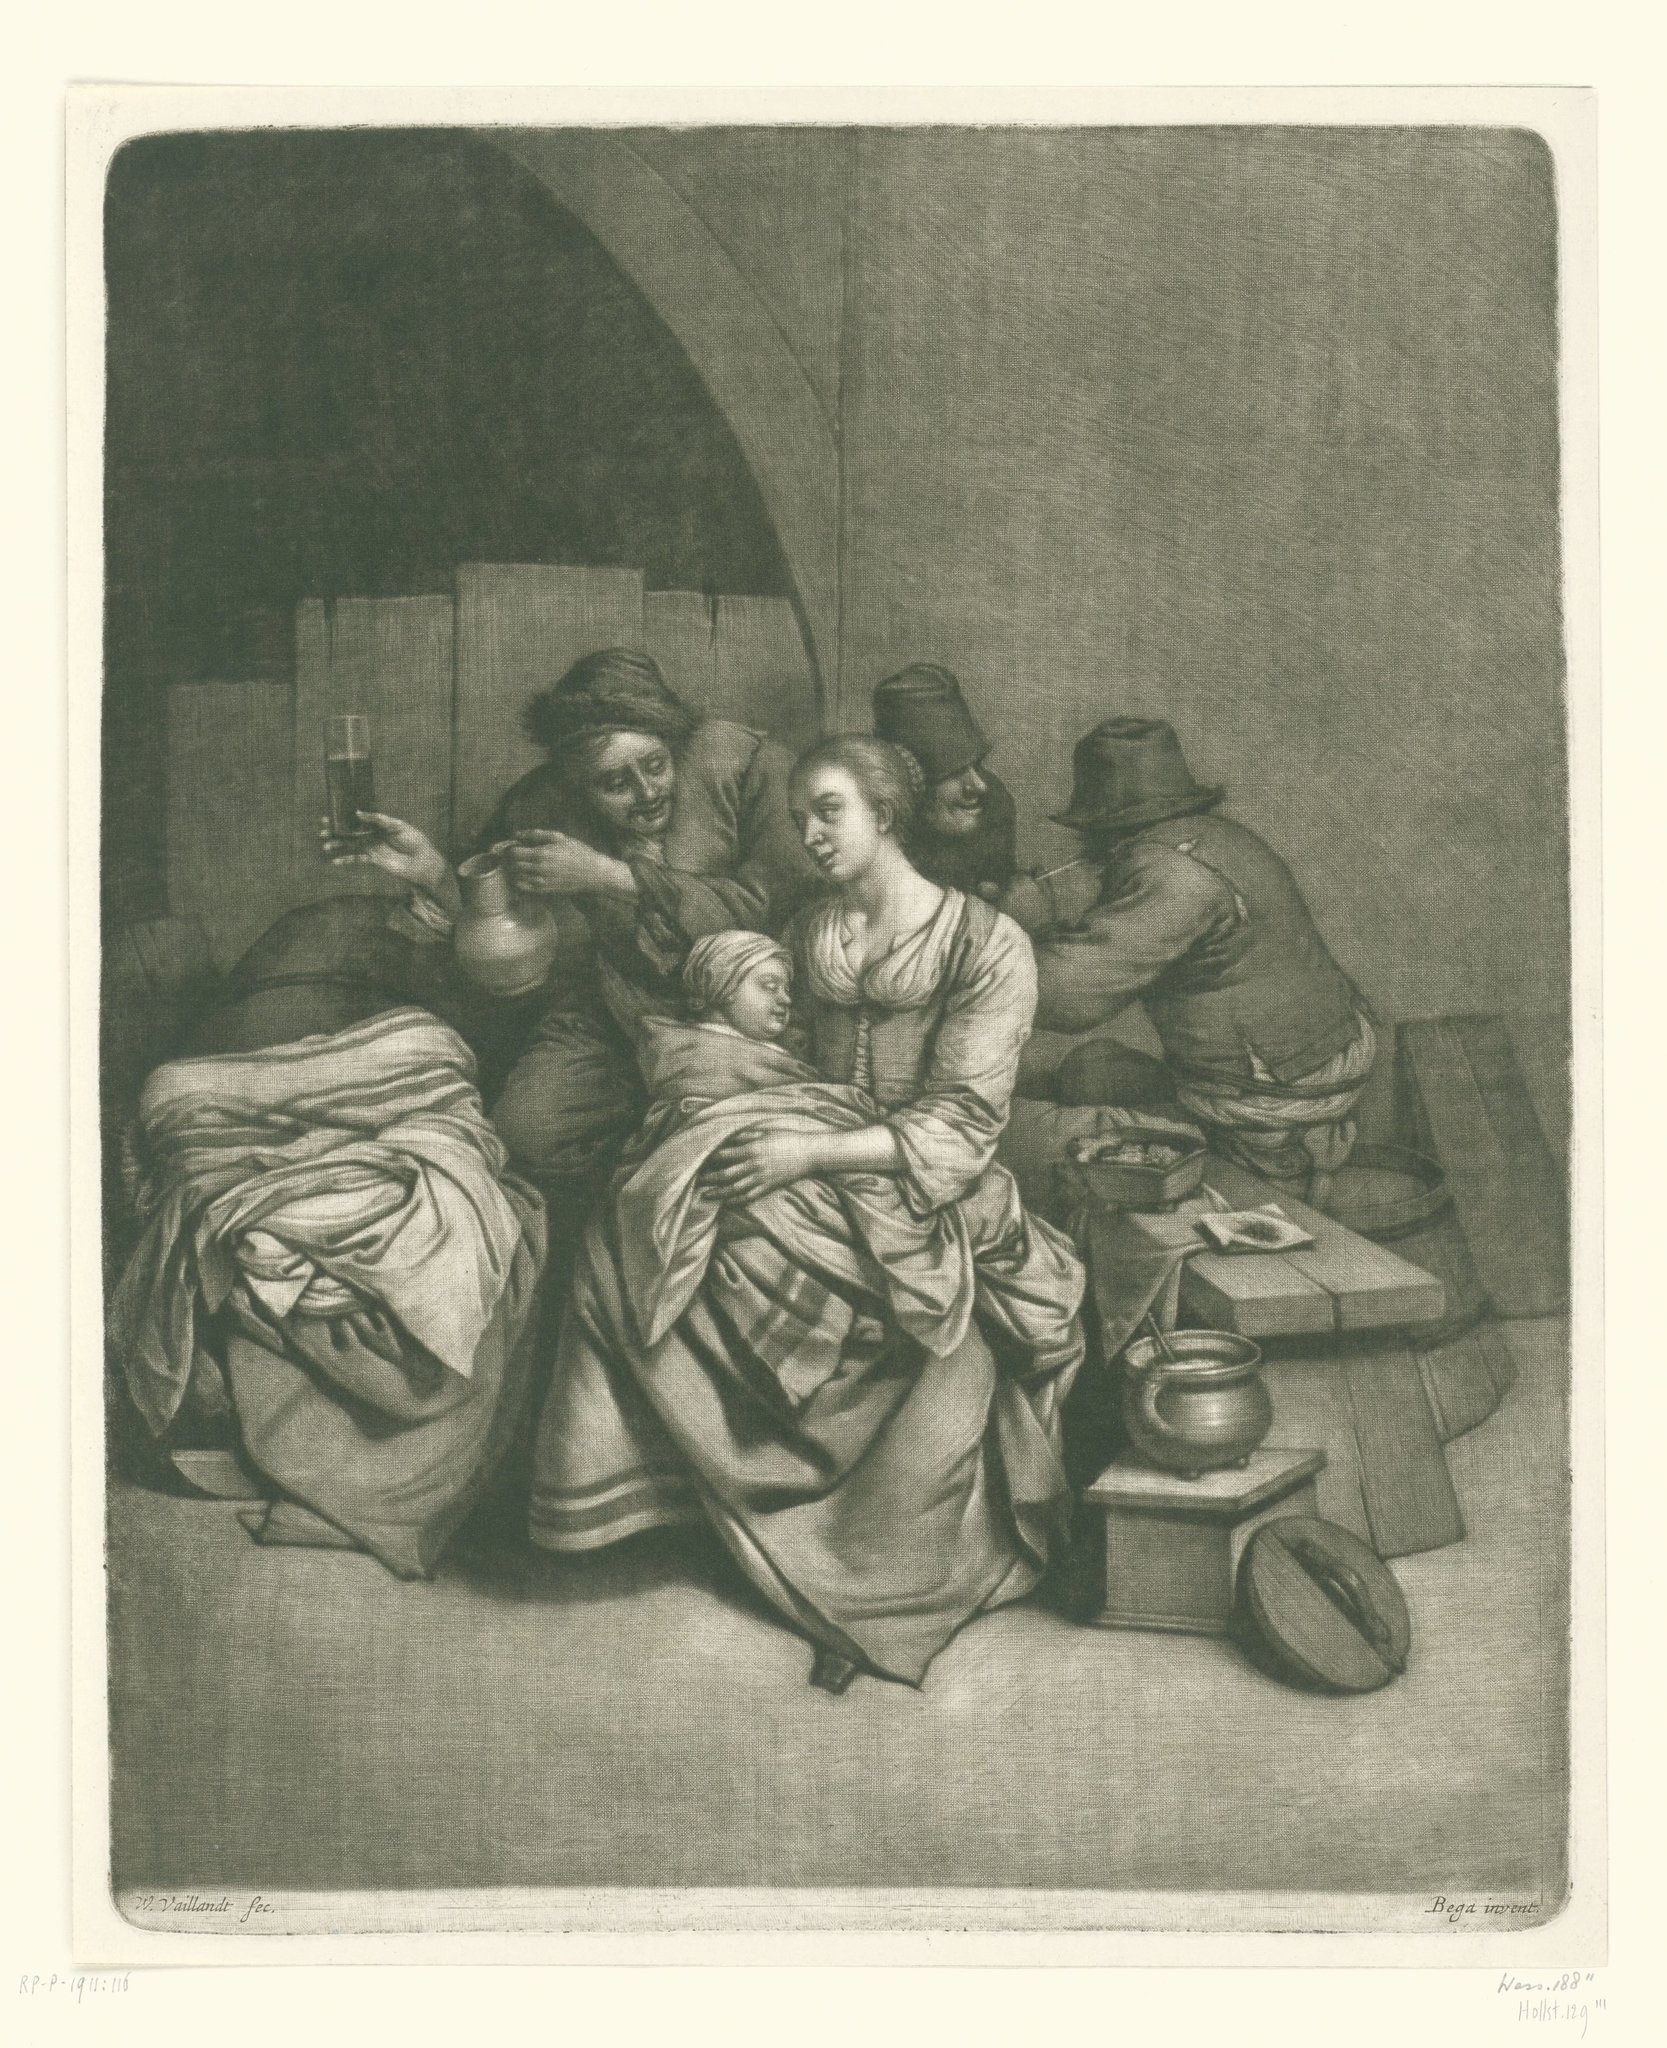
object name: print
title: Vrouw met een slapend kind in een herberg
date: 1658-1677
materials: paper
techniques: mezzotint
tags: inn, coffee-house, public house, etc., pipe ~ tobacco, mother and baby or young child, watching a sleeping child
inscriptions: collector's mark: Lugt 2228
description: In een herberg zit een een vrouw met een slapend kind op haar schoot tussen de pijprokende en drinkende mannen. Naast haar staat een pot met eten op een stoofje.